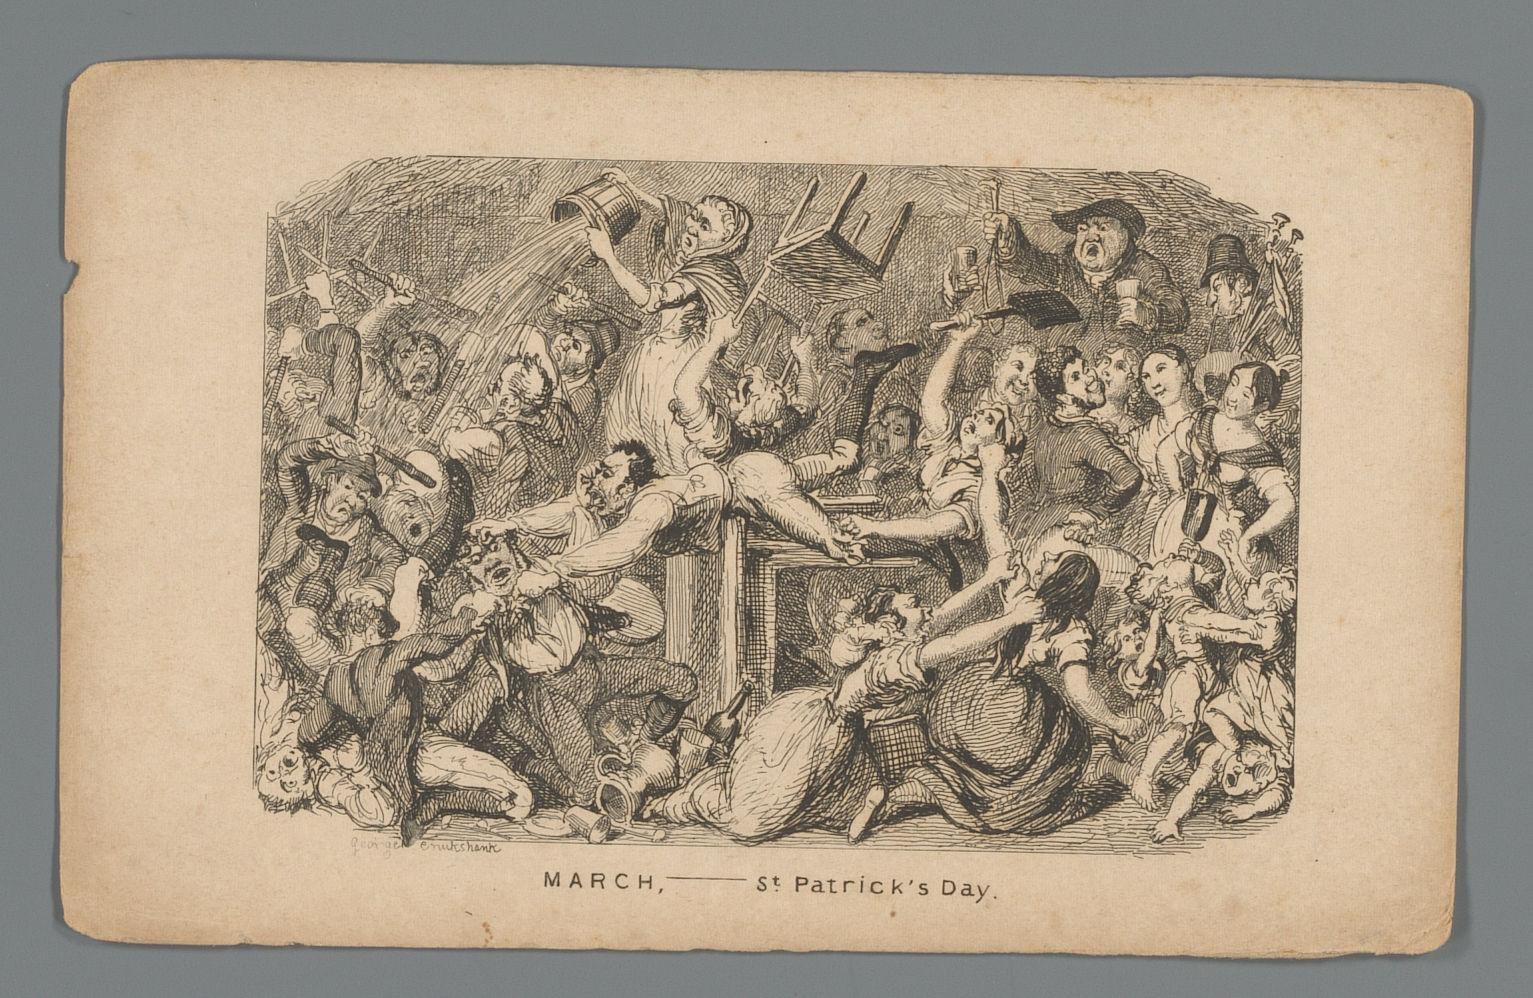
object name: book illustration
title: March, - St. Patrick's Day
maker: george cruikshank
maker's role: painter, print maker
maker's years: 1792-1878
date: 1838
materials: paper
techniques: etching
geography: england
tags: march; 'marzo' (ripa), st. patrick's day (march 17), drunken brawl (usually peasants fighting in an inn), political caricatures and satires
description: Knokpartij in een herberg. Illustratie voor de maand maart uit een uitgave van: The Comic Almanack (1838).